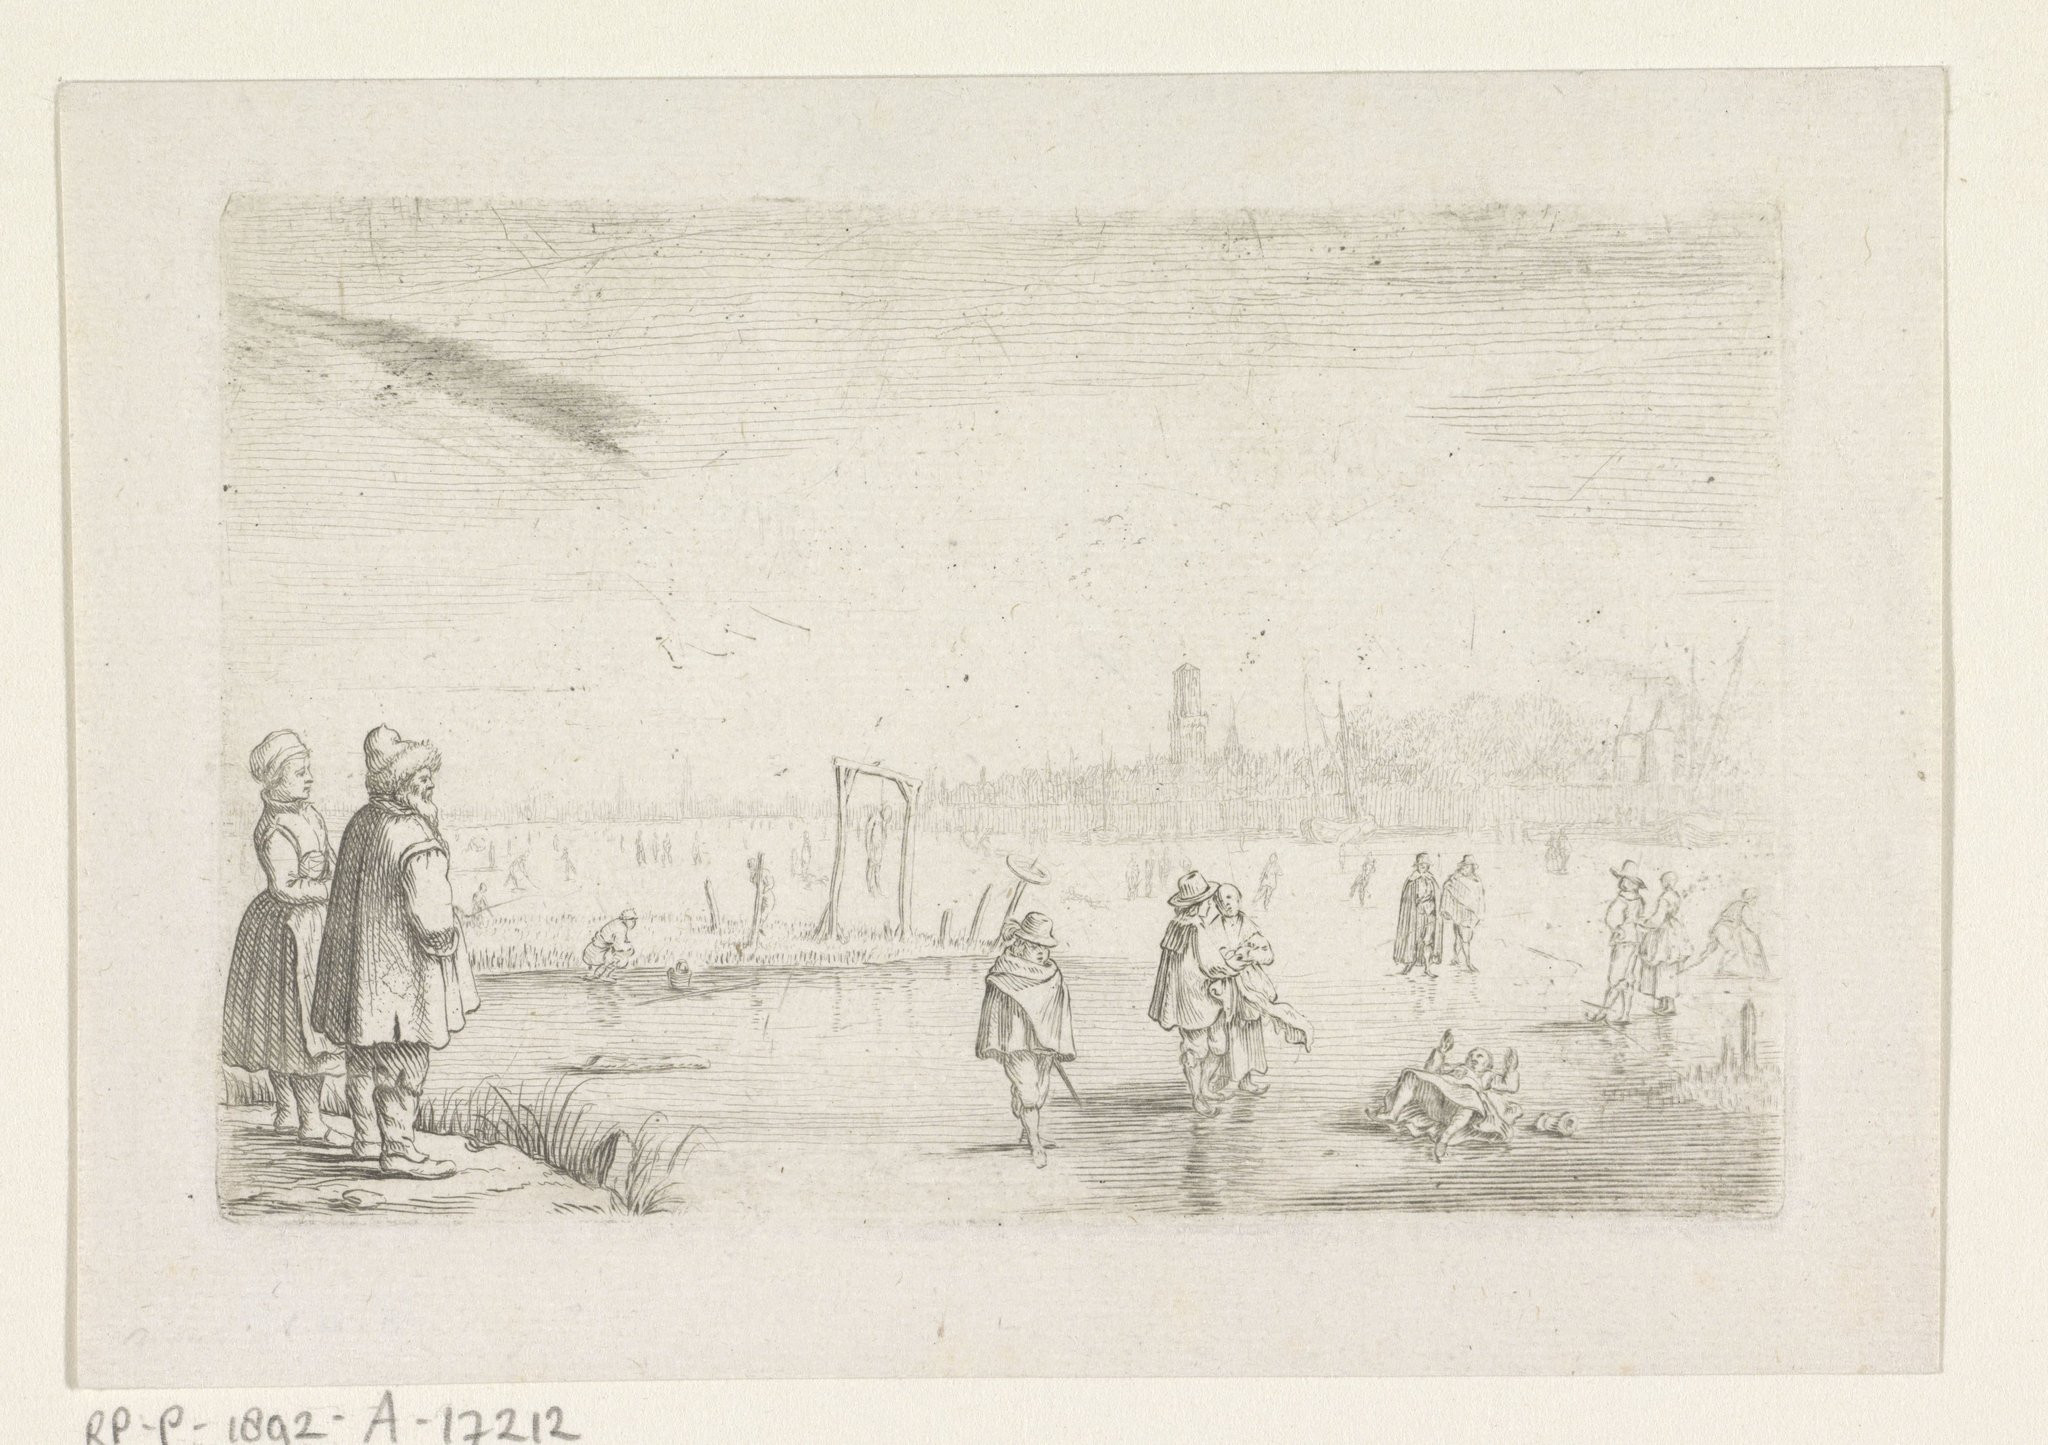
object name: print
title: IJsvermaak op een rivier bij een stad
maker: Anonymous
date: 1600-1700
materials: paper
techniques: engraving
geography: netherlands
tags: city-view in general; 'veduta', winter sports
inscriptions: collector's mark: Lugt 2228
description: IJsvermaak op een bevroren rivier bij een stad. Links op de voorgrond staan een boer en boerin naar de schaatsenrijders te kijken. Rechts valt een schaatsenrijdster achterover op het ijs. Op de achtergrond hangt een lijk aan de galg. Aan de overkant van de bervoren rivier een stad.